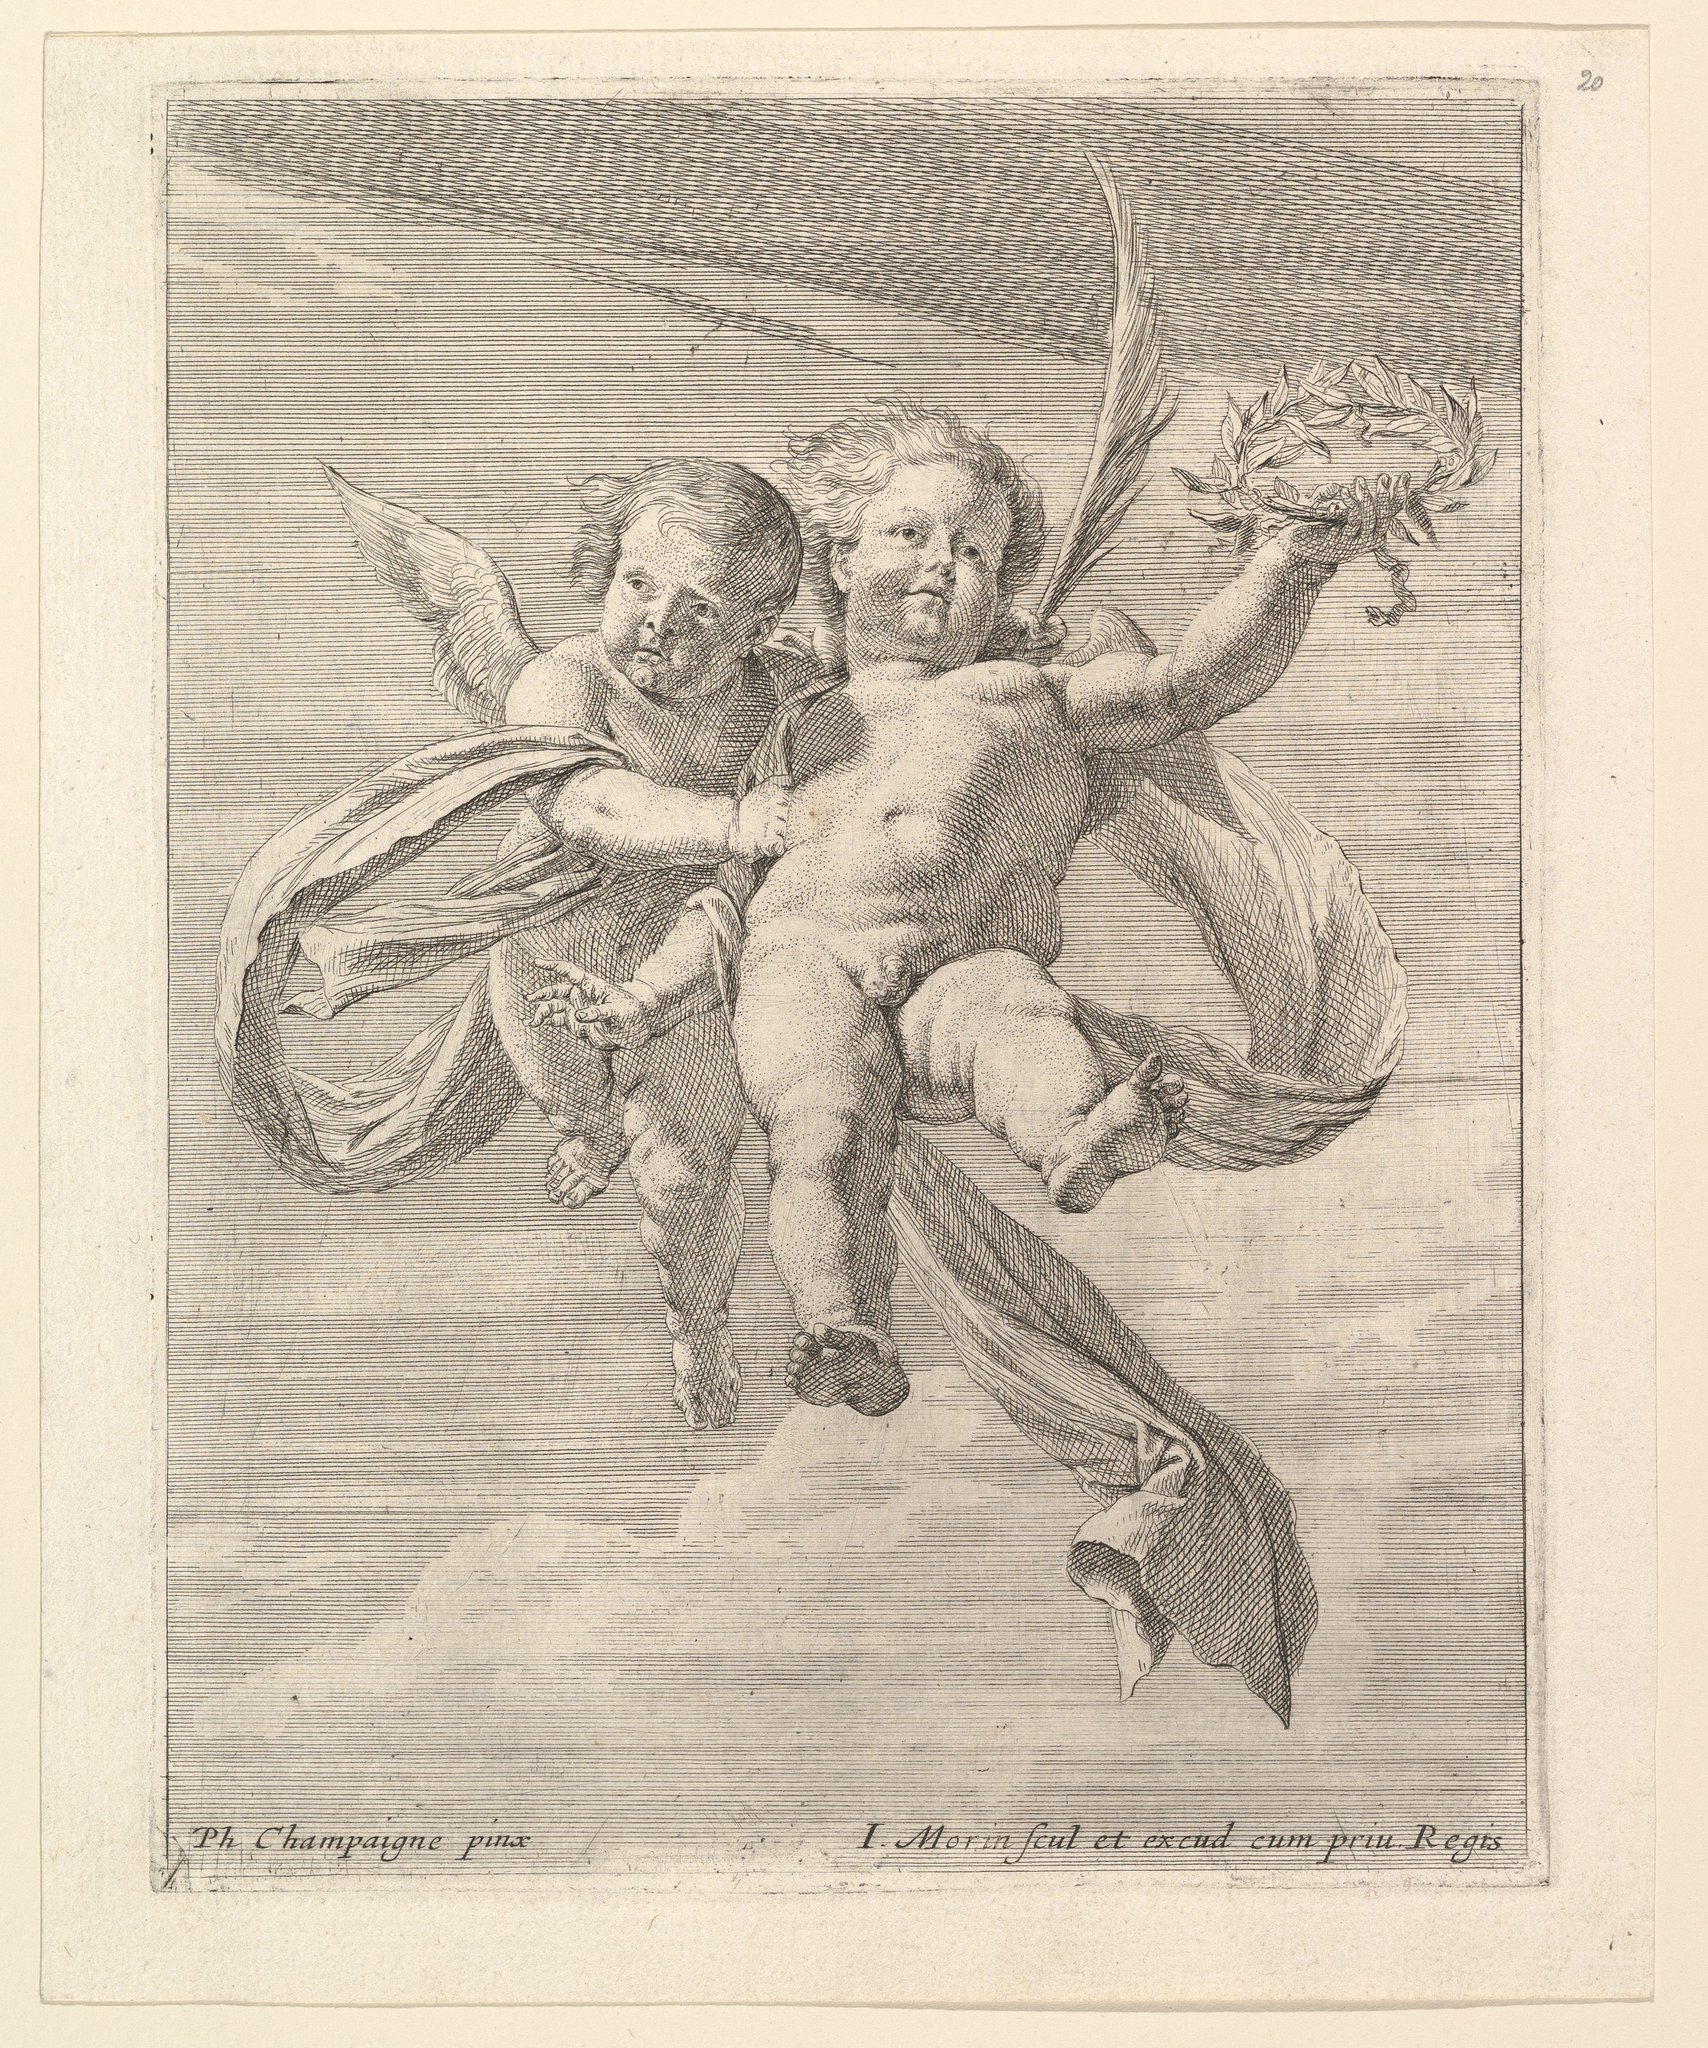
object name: print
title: Groupe de deux angelots (l'un regardant de face et l'autre vers la gauche)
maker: jean morin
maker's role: artist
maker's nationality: french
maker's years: 1605-1650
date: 1605-1650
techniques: etching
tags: diadems,angels